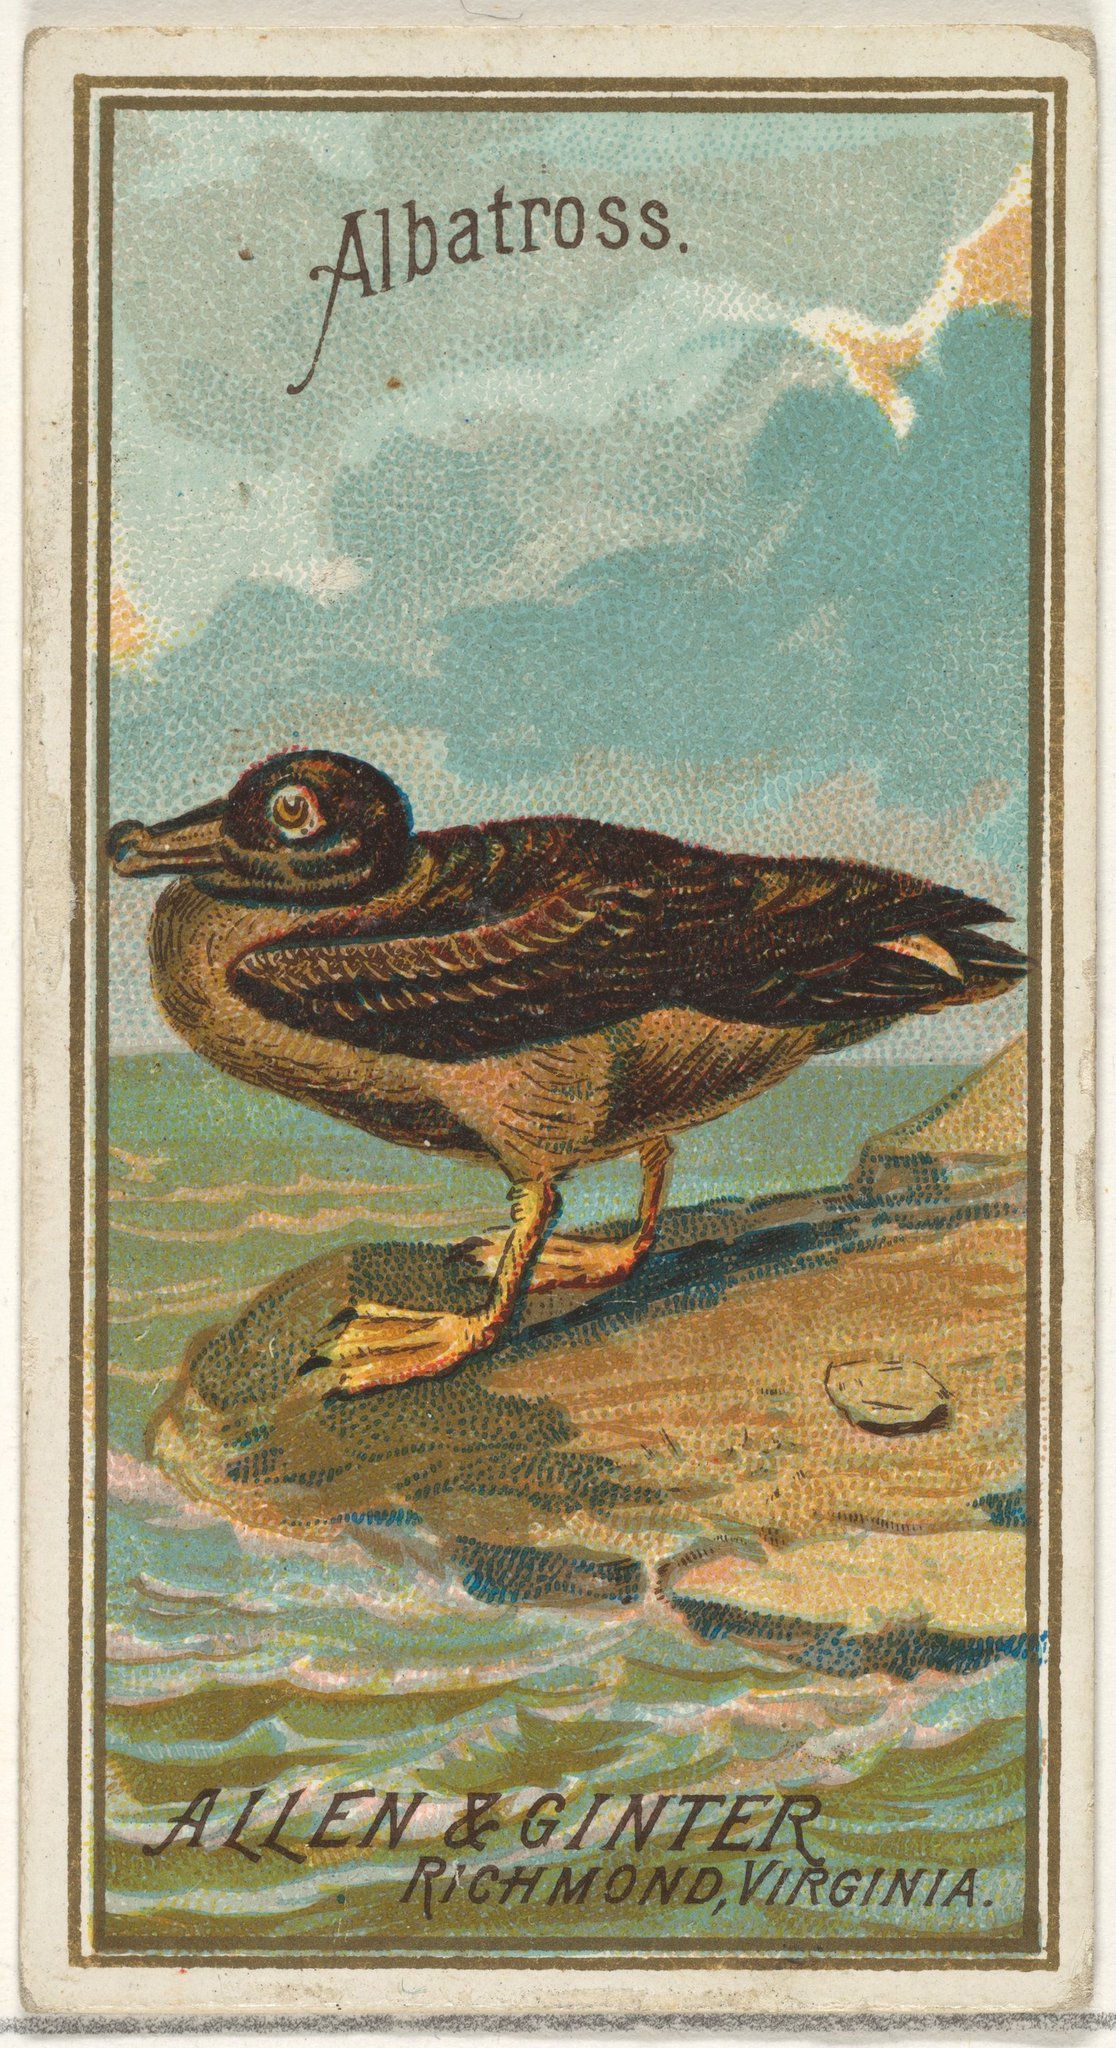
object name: print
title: Albatross, from the Birds of America series (N4) for Allen & Ginter Cigarettes Brands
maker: allen & ginter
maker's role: publisher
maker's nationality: american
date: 1888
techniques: color lithograph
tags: birds